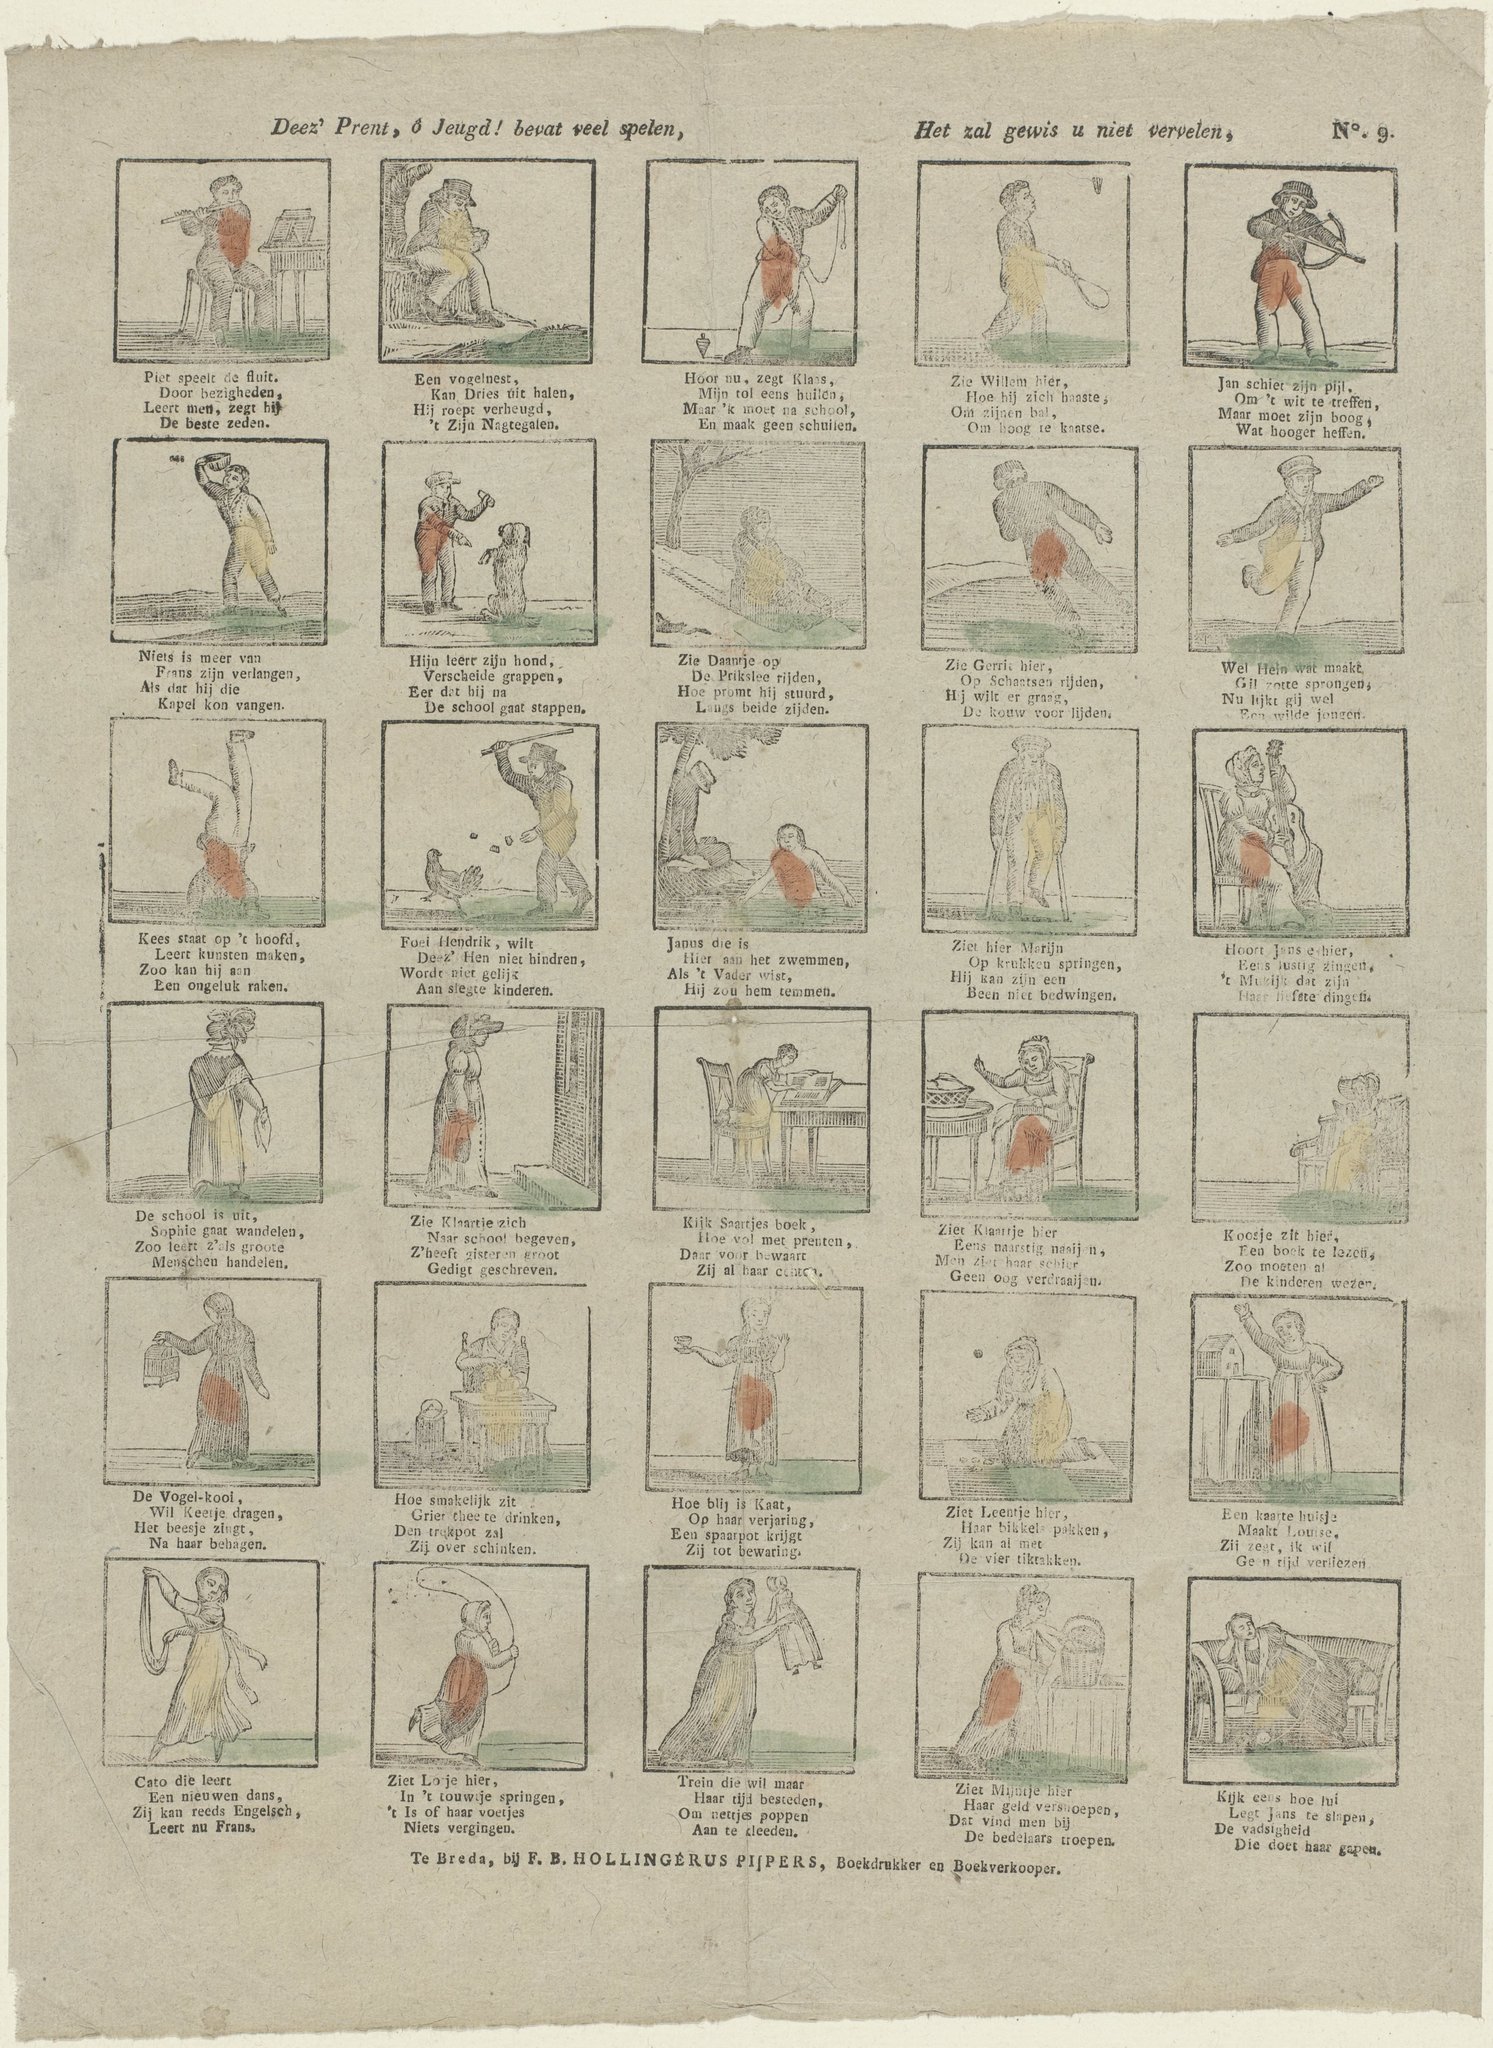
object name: print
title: Deez' prent, ô jeugd! bevat veel spelen, / Het zal gewis u niet vervelen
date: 1815-1825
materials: paper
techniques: colour, letterpress printing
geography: breda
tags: children's games and plays, skates (winter sports), games using special objects (marbles, top, hoop, etc.), jumping-rope games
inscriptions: collector's mark: Lugt 2228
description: Blad met 30 voorstellingen van kinderspelen en bezigheden, zoals fluiten, zwemmen en touwtjespringen. Onder elke afbeelding een vierregelig vers. Genummerd rechtsboven: No. 9.